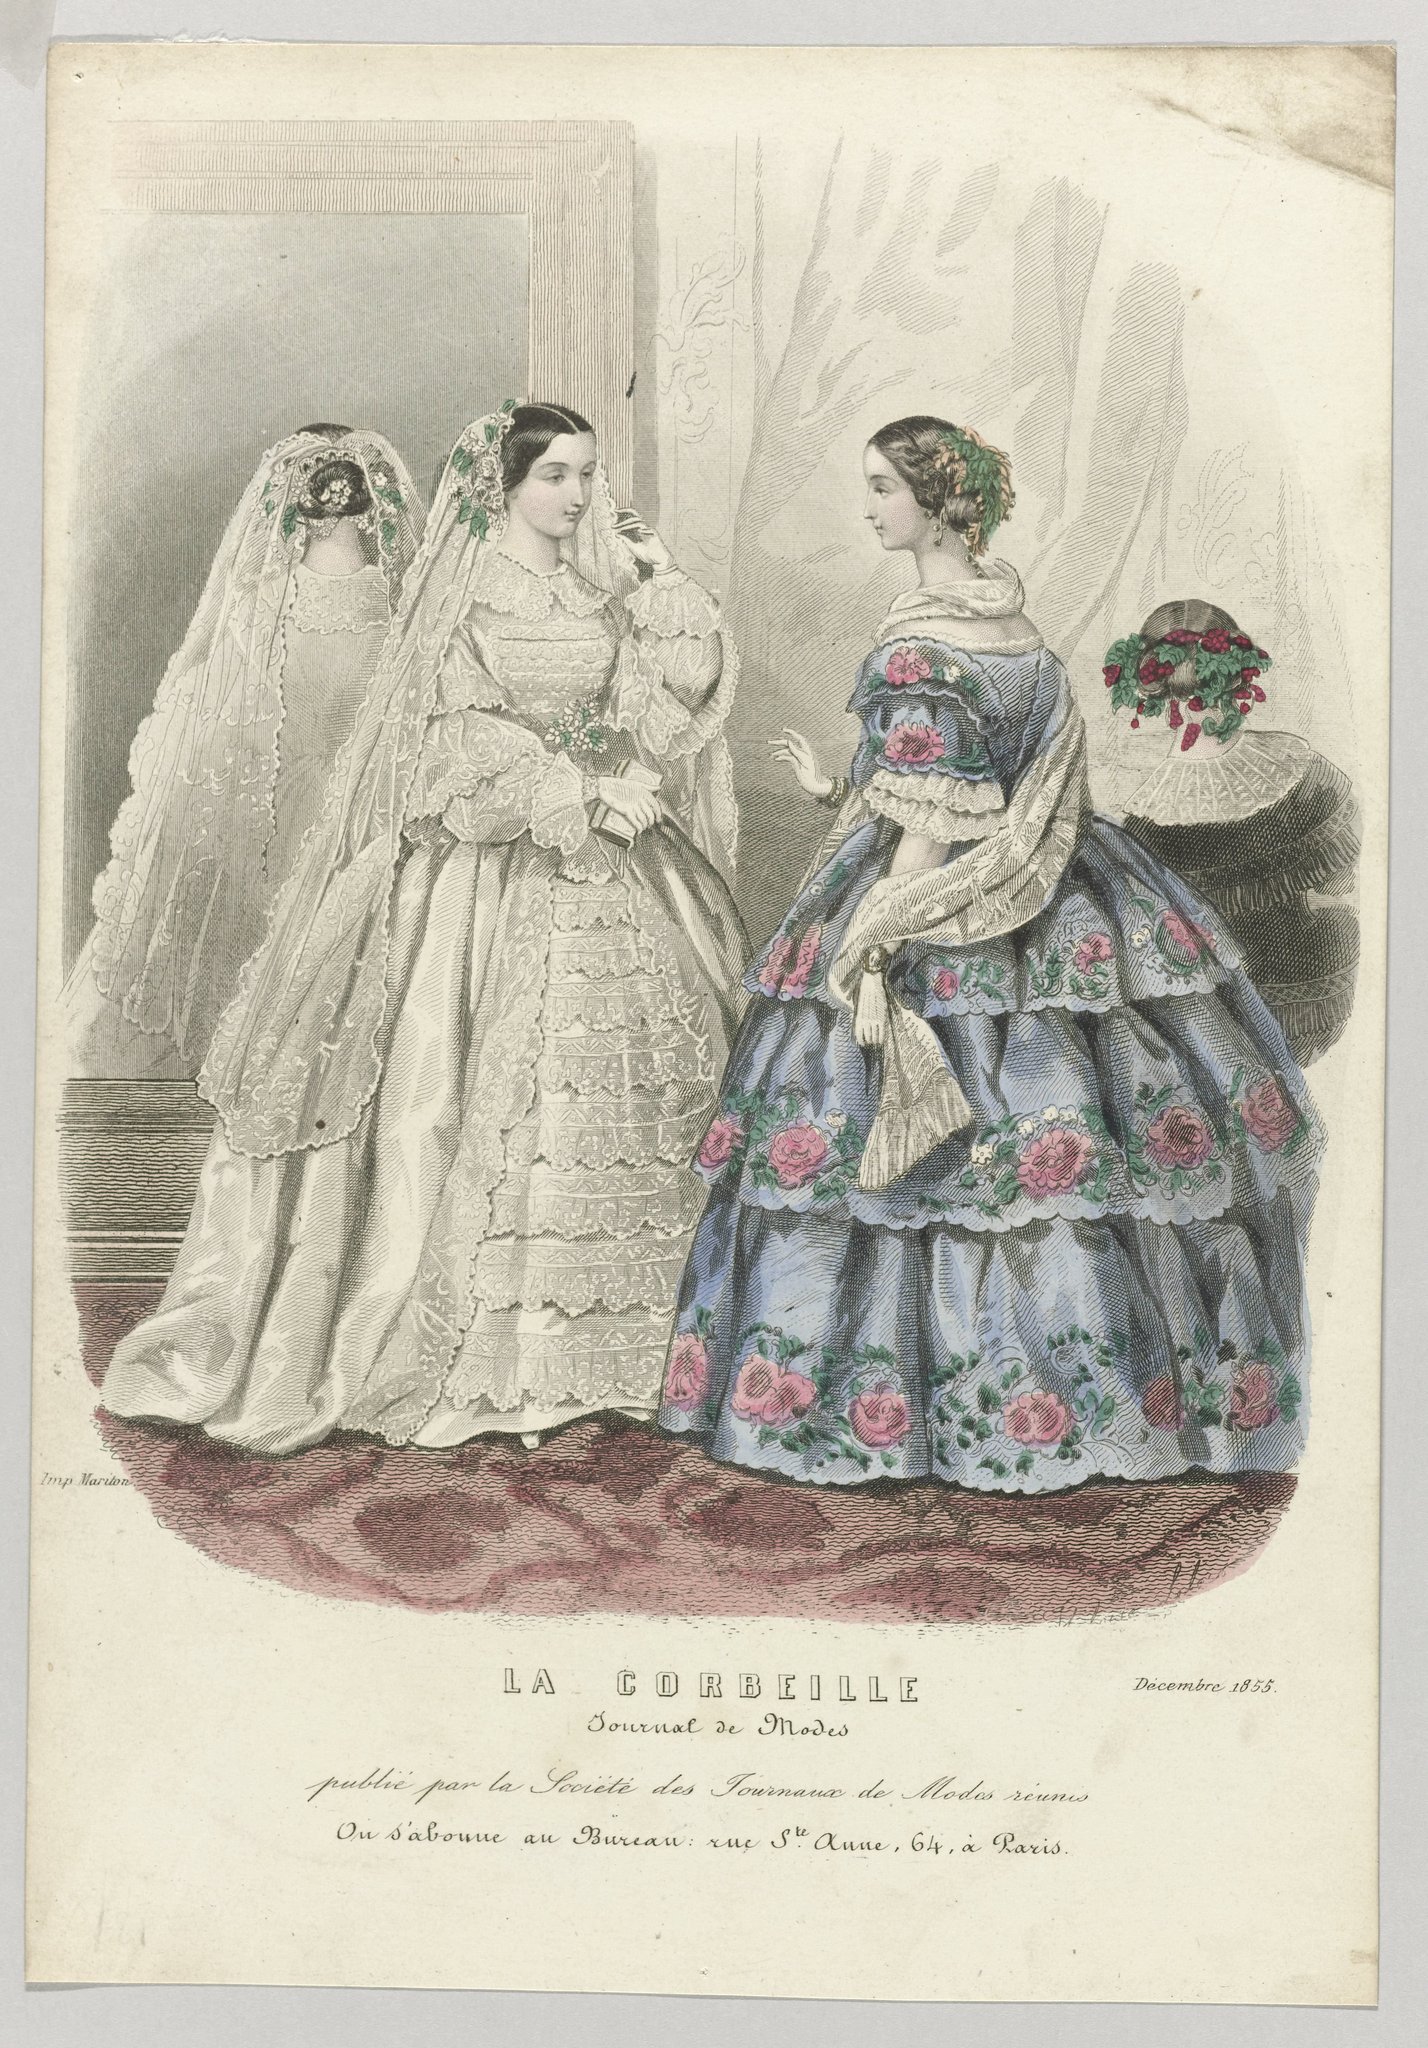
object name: fashion print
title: La Corbeille, décembre 1855 : Journal de Modes (...)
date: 1855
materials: paper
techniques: engraving, hand coloring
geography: paris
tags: gloves, mittens (long gloves) (+ women's clothes), clothing for the upper part of the body (shawl) (+ women's clothes), veil (+ women's clothes), reflection (in a mirror) - aa - (for) women (+ back view), fashion plates, bride (in wedding-dress), bracelet, wristlet (+ women's clothes)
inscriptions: address: ‘On 's abonne au Bureau: rue S.te Anne, 64, à Paris.’, caption: ‘publié par la Société des Journaux de Modes réunis’, title: ‘La Corbeille / Journal de Modes’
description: Drie vrouwen, van wie één op de rug gezien, in een interieur. De bruid staat met de rug naar een grote spiegel. Links: hooggesloten bruidsjapon met lange mouwen. Het kapsel is versierd met bloemen, haarkam(?) en doorzichtige sluier. Midden: japon met bloem- en bladmotief en geschulpte zoom. Boothals, halflange mouwen en wijde rok met drie gerimpelde stroken stof. Accessoires: sjaal, korte handschoenen, armbanden om beide polsen. Rechts: kapsel versierd met bladeren en druiventrossen. Onder de voorstelling enkele regels informatie over het modetijdschrift. Prent uit het modetijdschrift La Corbeille (1840-1878).